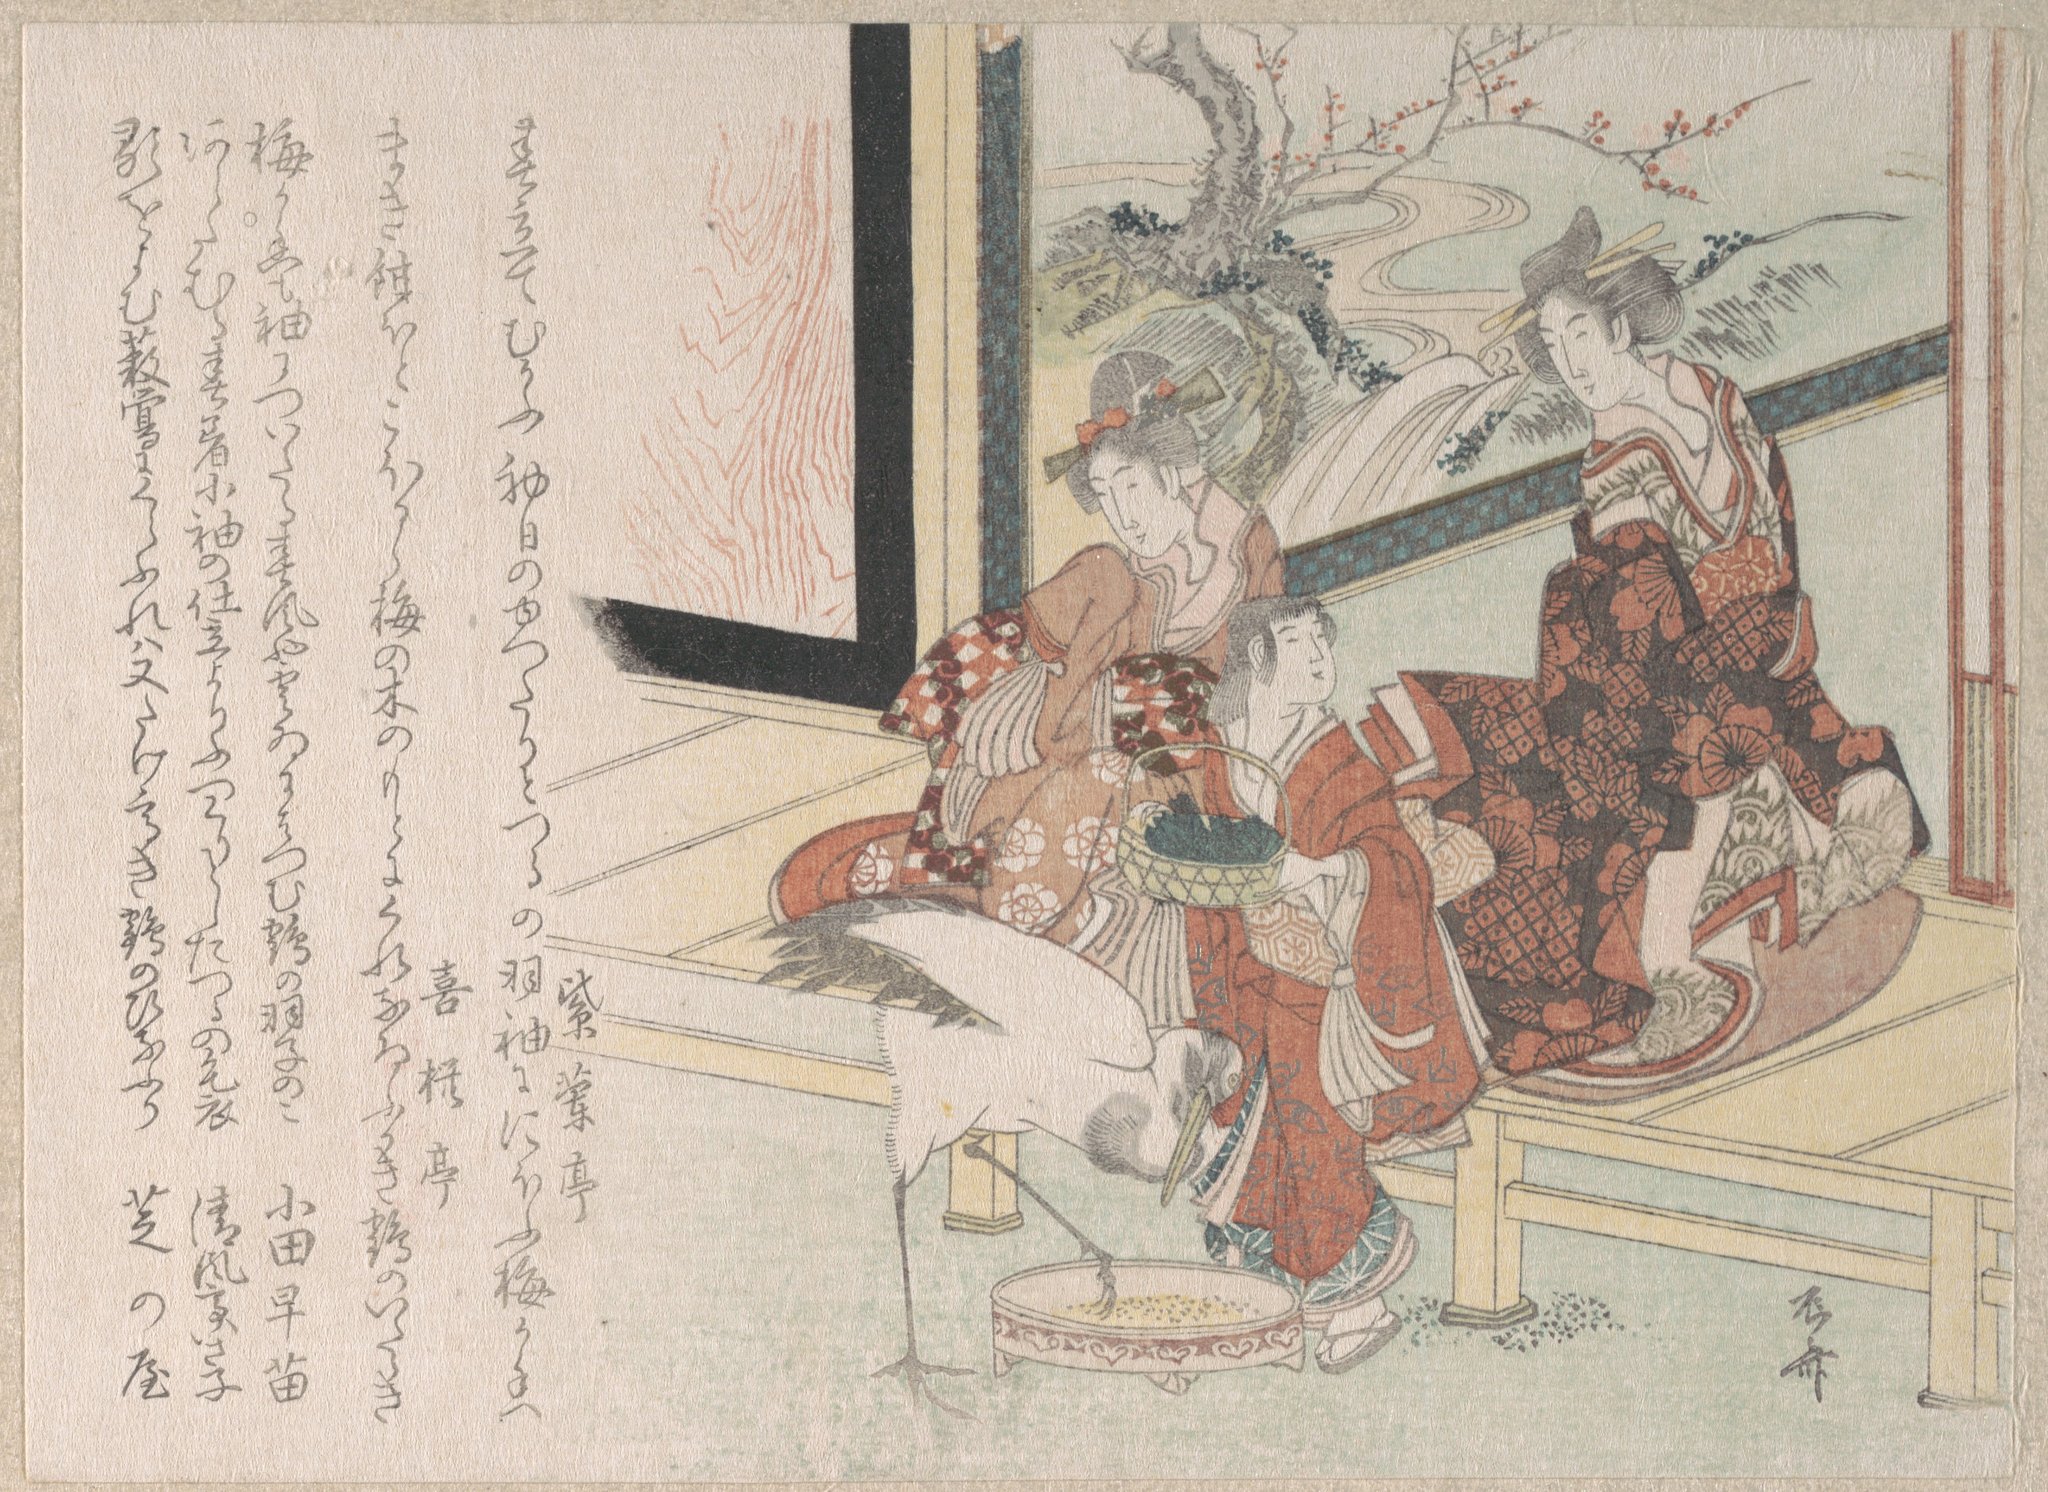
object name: print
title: Two Women and a Girl Feeding a Crane at the Verandah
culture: japanese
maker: ryūryūkyo shinsai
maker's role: artist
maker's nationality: japanese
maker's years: 1799-1823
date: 1801-1900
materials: ink, paper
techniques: surimono, woodblock print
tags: cranes,girls,women